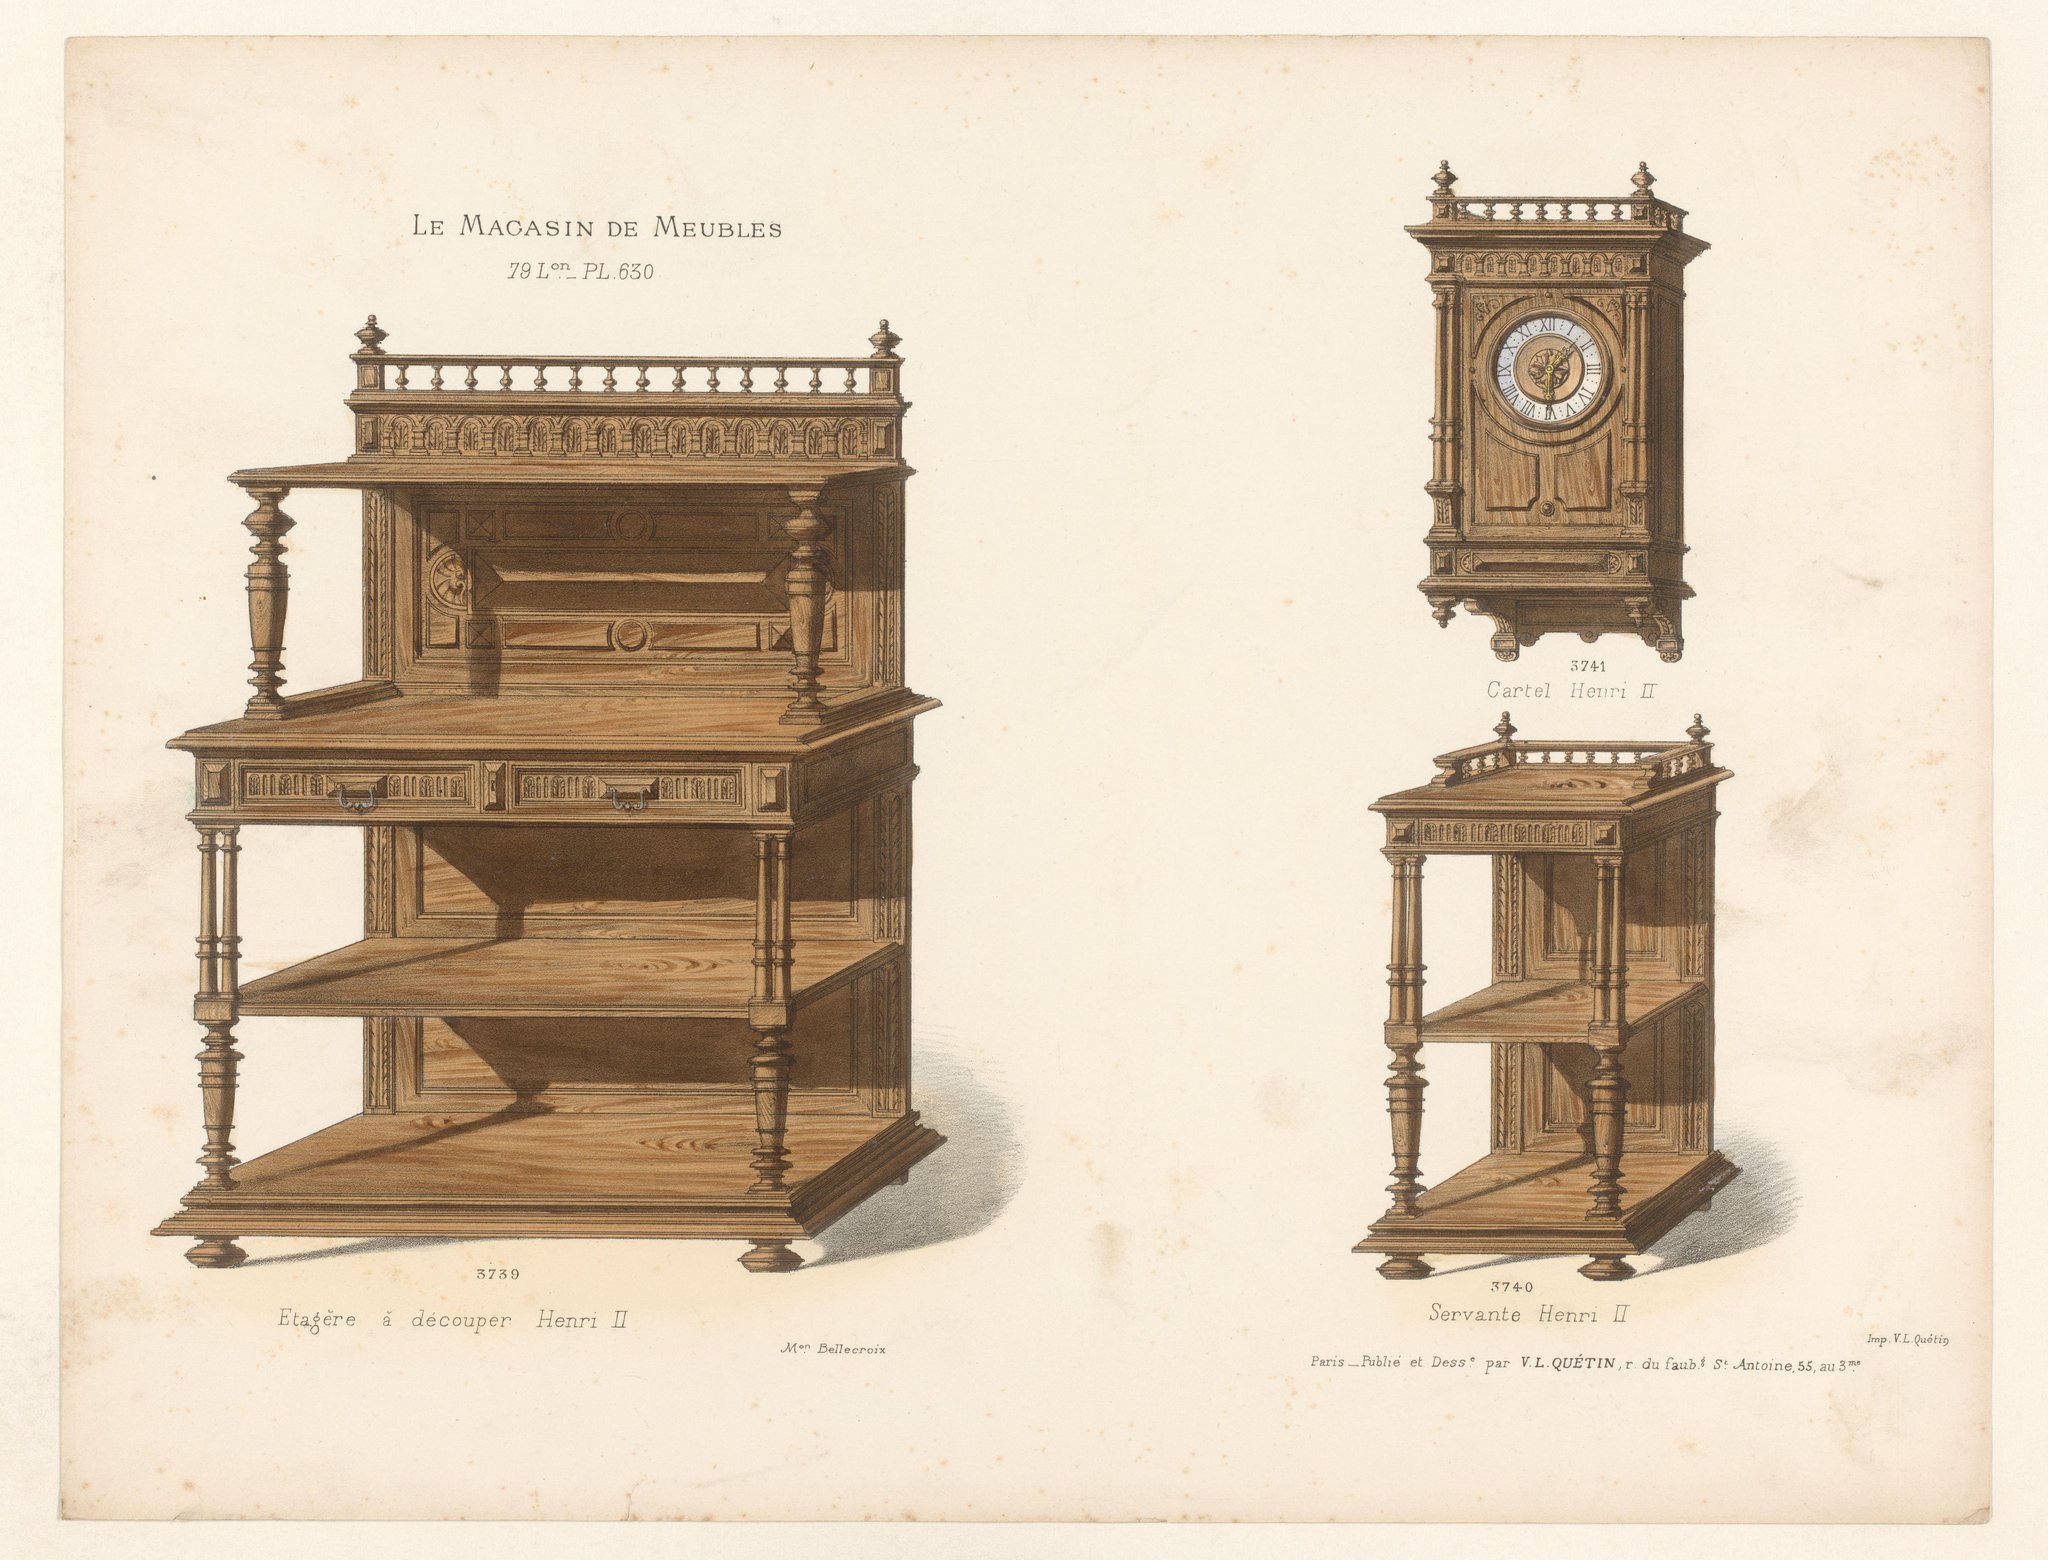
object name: print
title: Etagère à découper Henri II / Servante Henri II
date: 1878-1904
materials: paper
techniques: hand coloring, lithograph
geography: paris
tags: furniture for storage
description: Twee open kasten in de Hendrik II-stijl. Prent uit 79e Livraison.